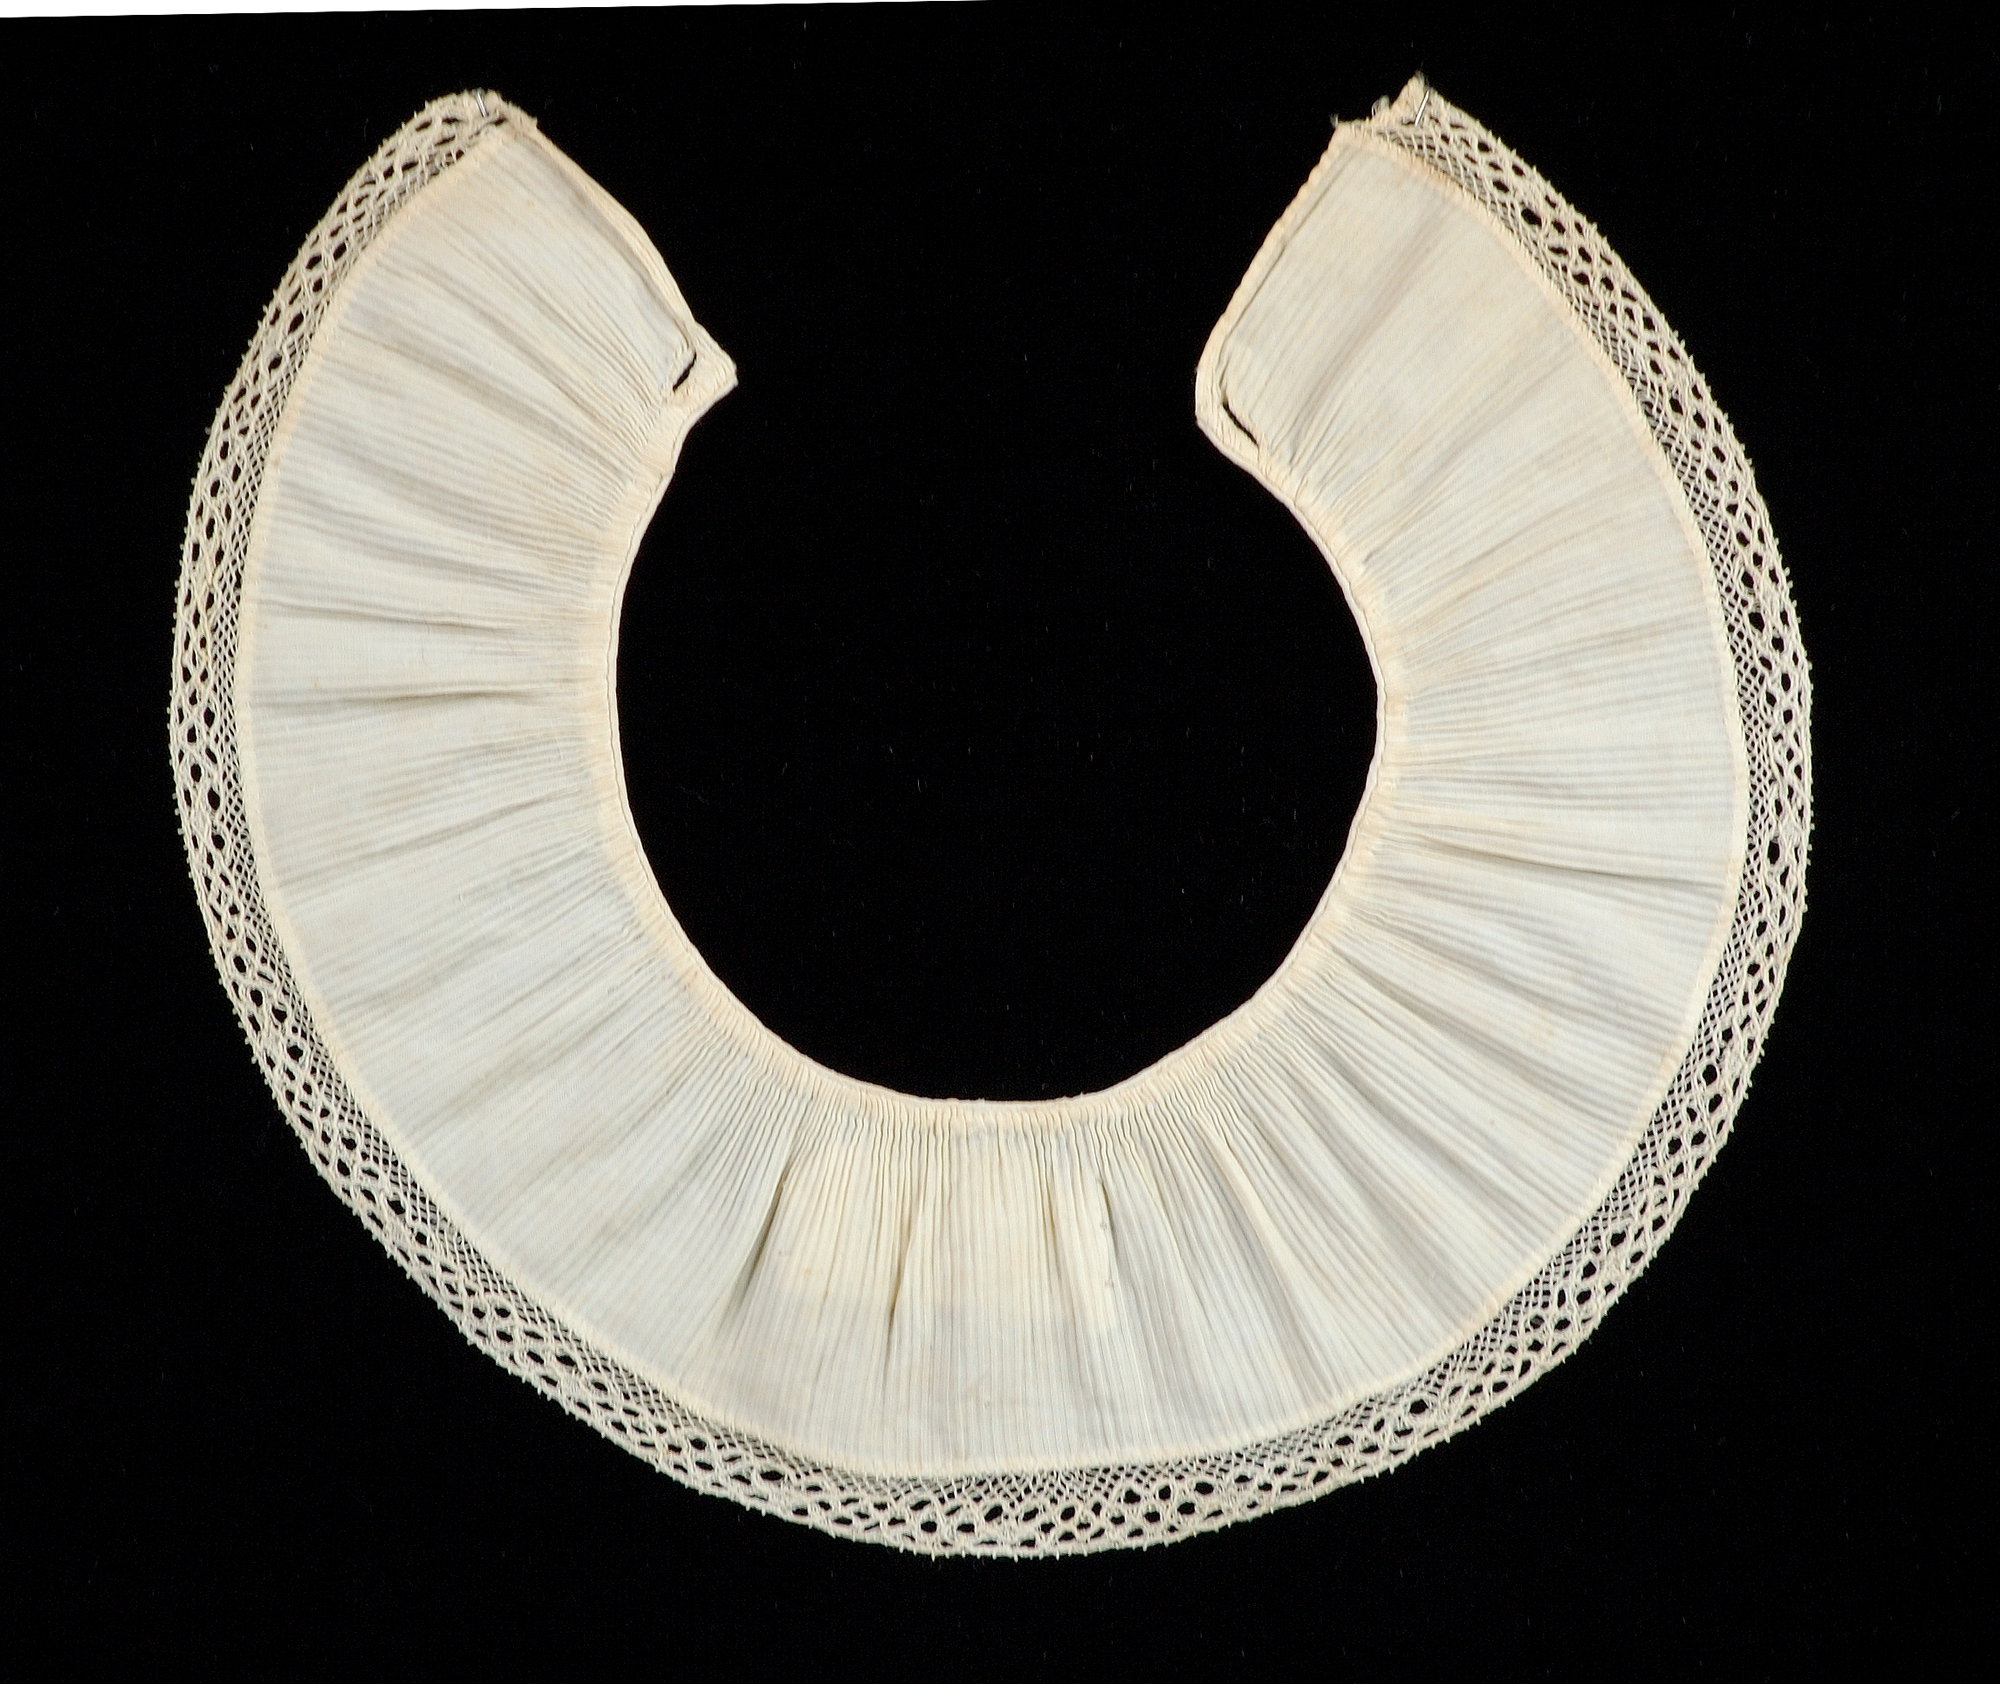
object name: collar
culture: american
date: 1850-1870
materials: cotton